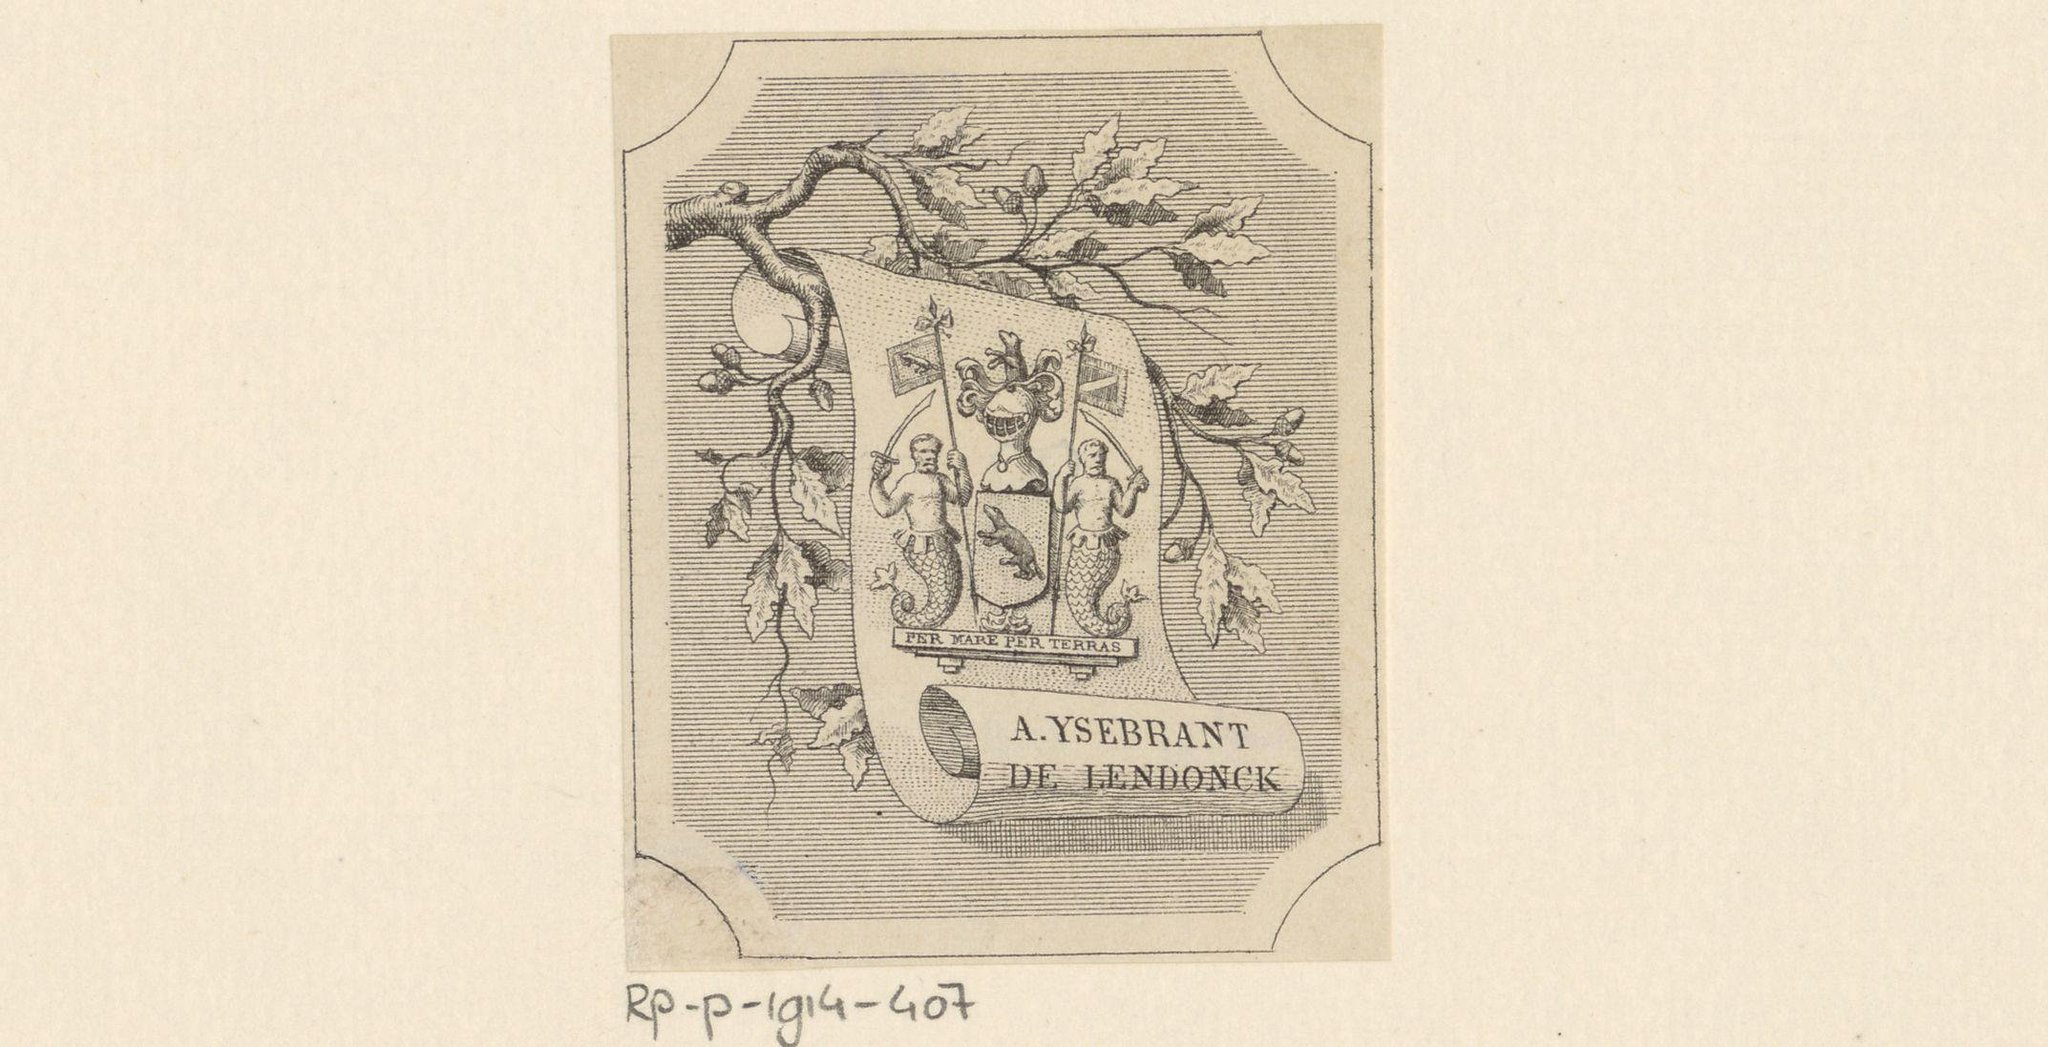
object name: bookplate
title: Ex libris van A. Ysebrant de Lendonck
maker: Anonymous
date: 1850-1899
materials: paper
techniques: etching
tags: trees: oak (+ branch, stick), armorial bearing, heraldry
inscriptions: collector's mark: Lugt 2760, collector's mark: Lugt 2233